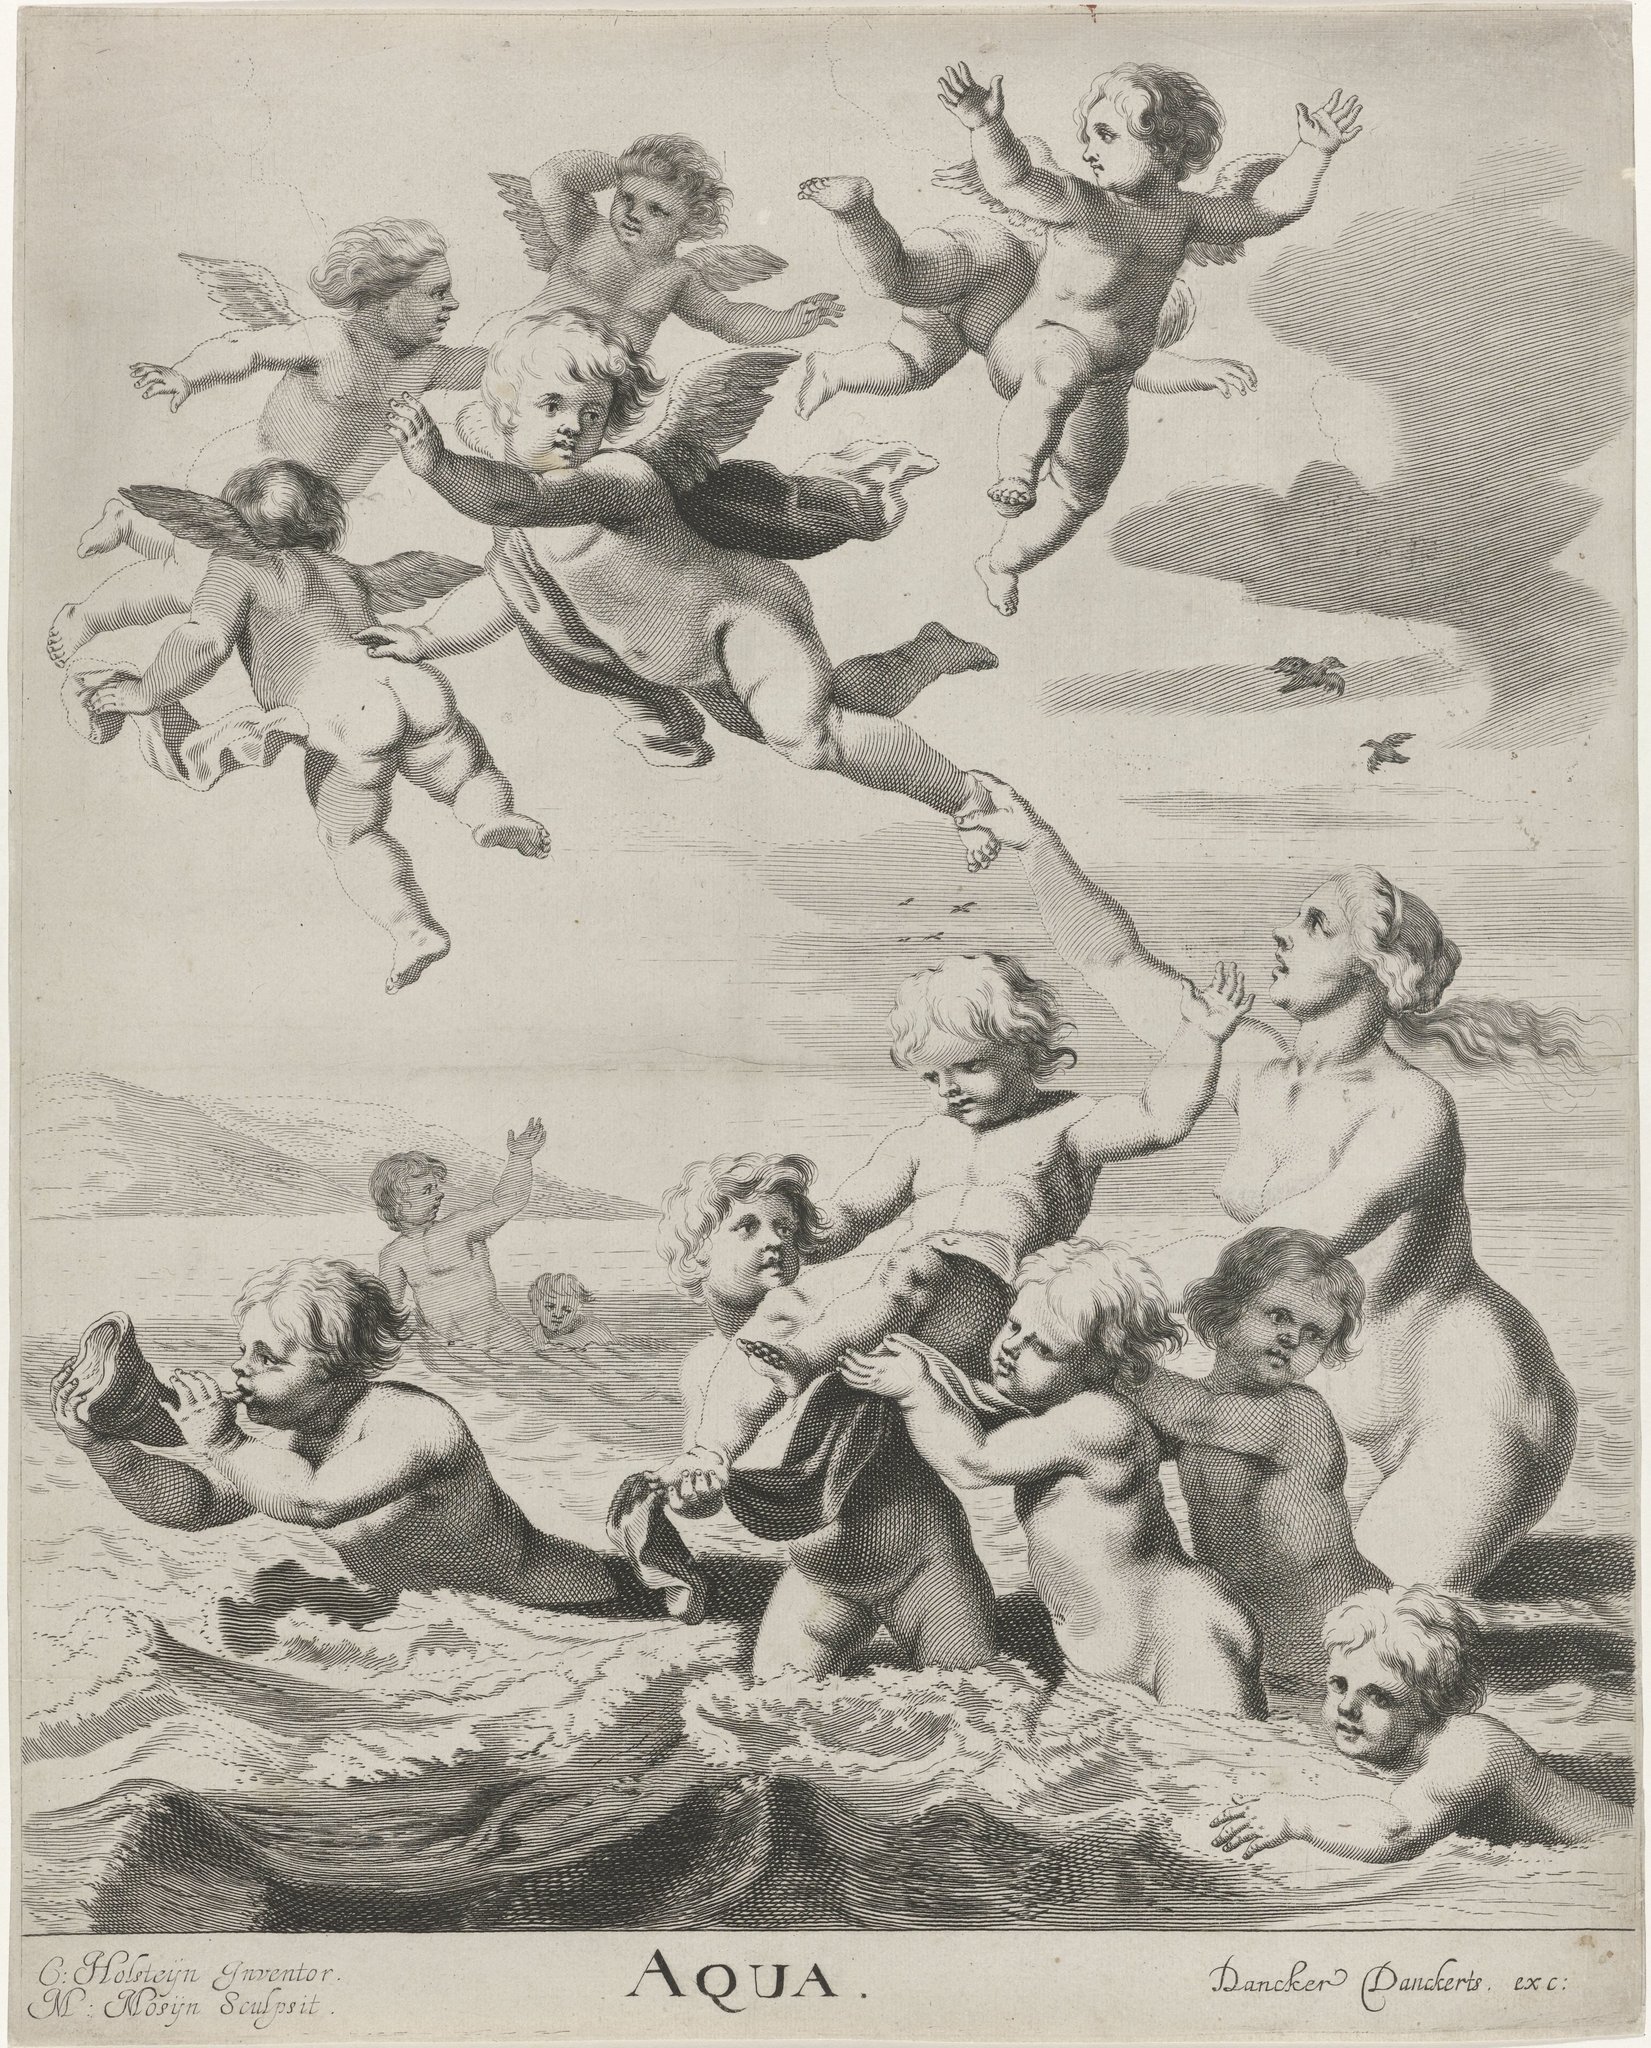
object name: print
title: Aqua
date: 1640-1655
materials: paper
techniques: engraving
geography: amsterdam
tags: water (one of the four elements), cupids: 'amores', 'amoretti', 'putti', sea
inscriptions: collector's mark: Lugt 2228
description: Spelende putti in het water en een groep vliegende putti daarboven. Een vrouw in het water grijpt een vliegende putto bij de enkel. Prent uit een serie van de vier elementen.